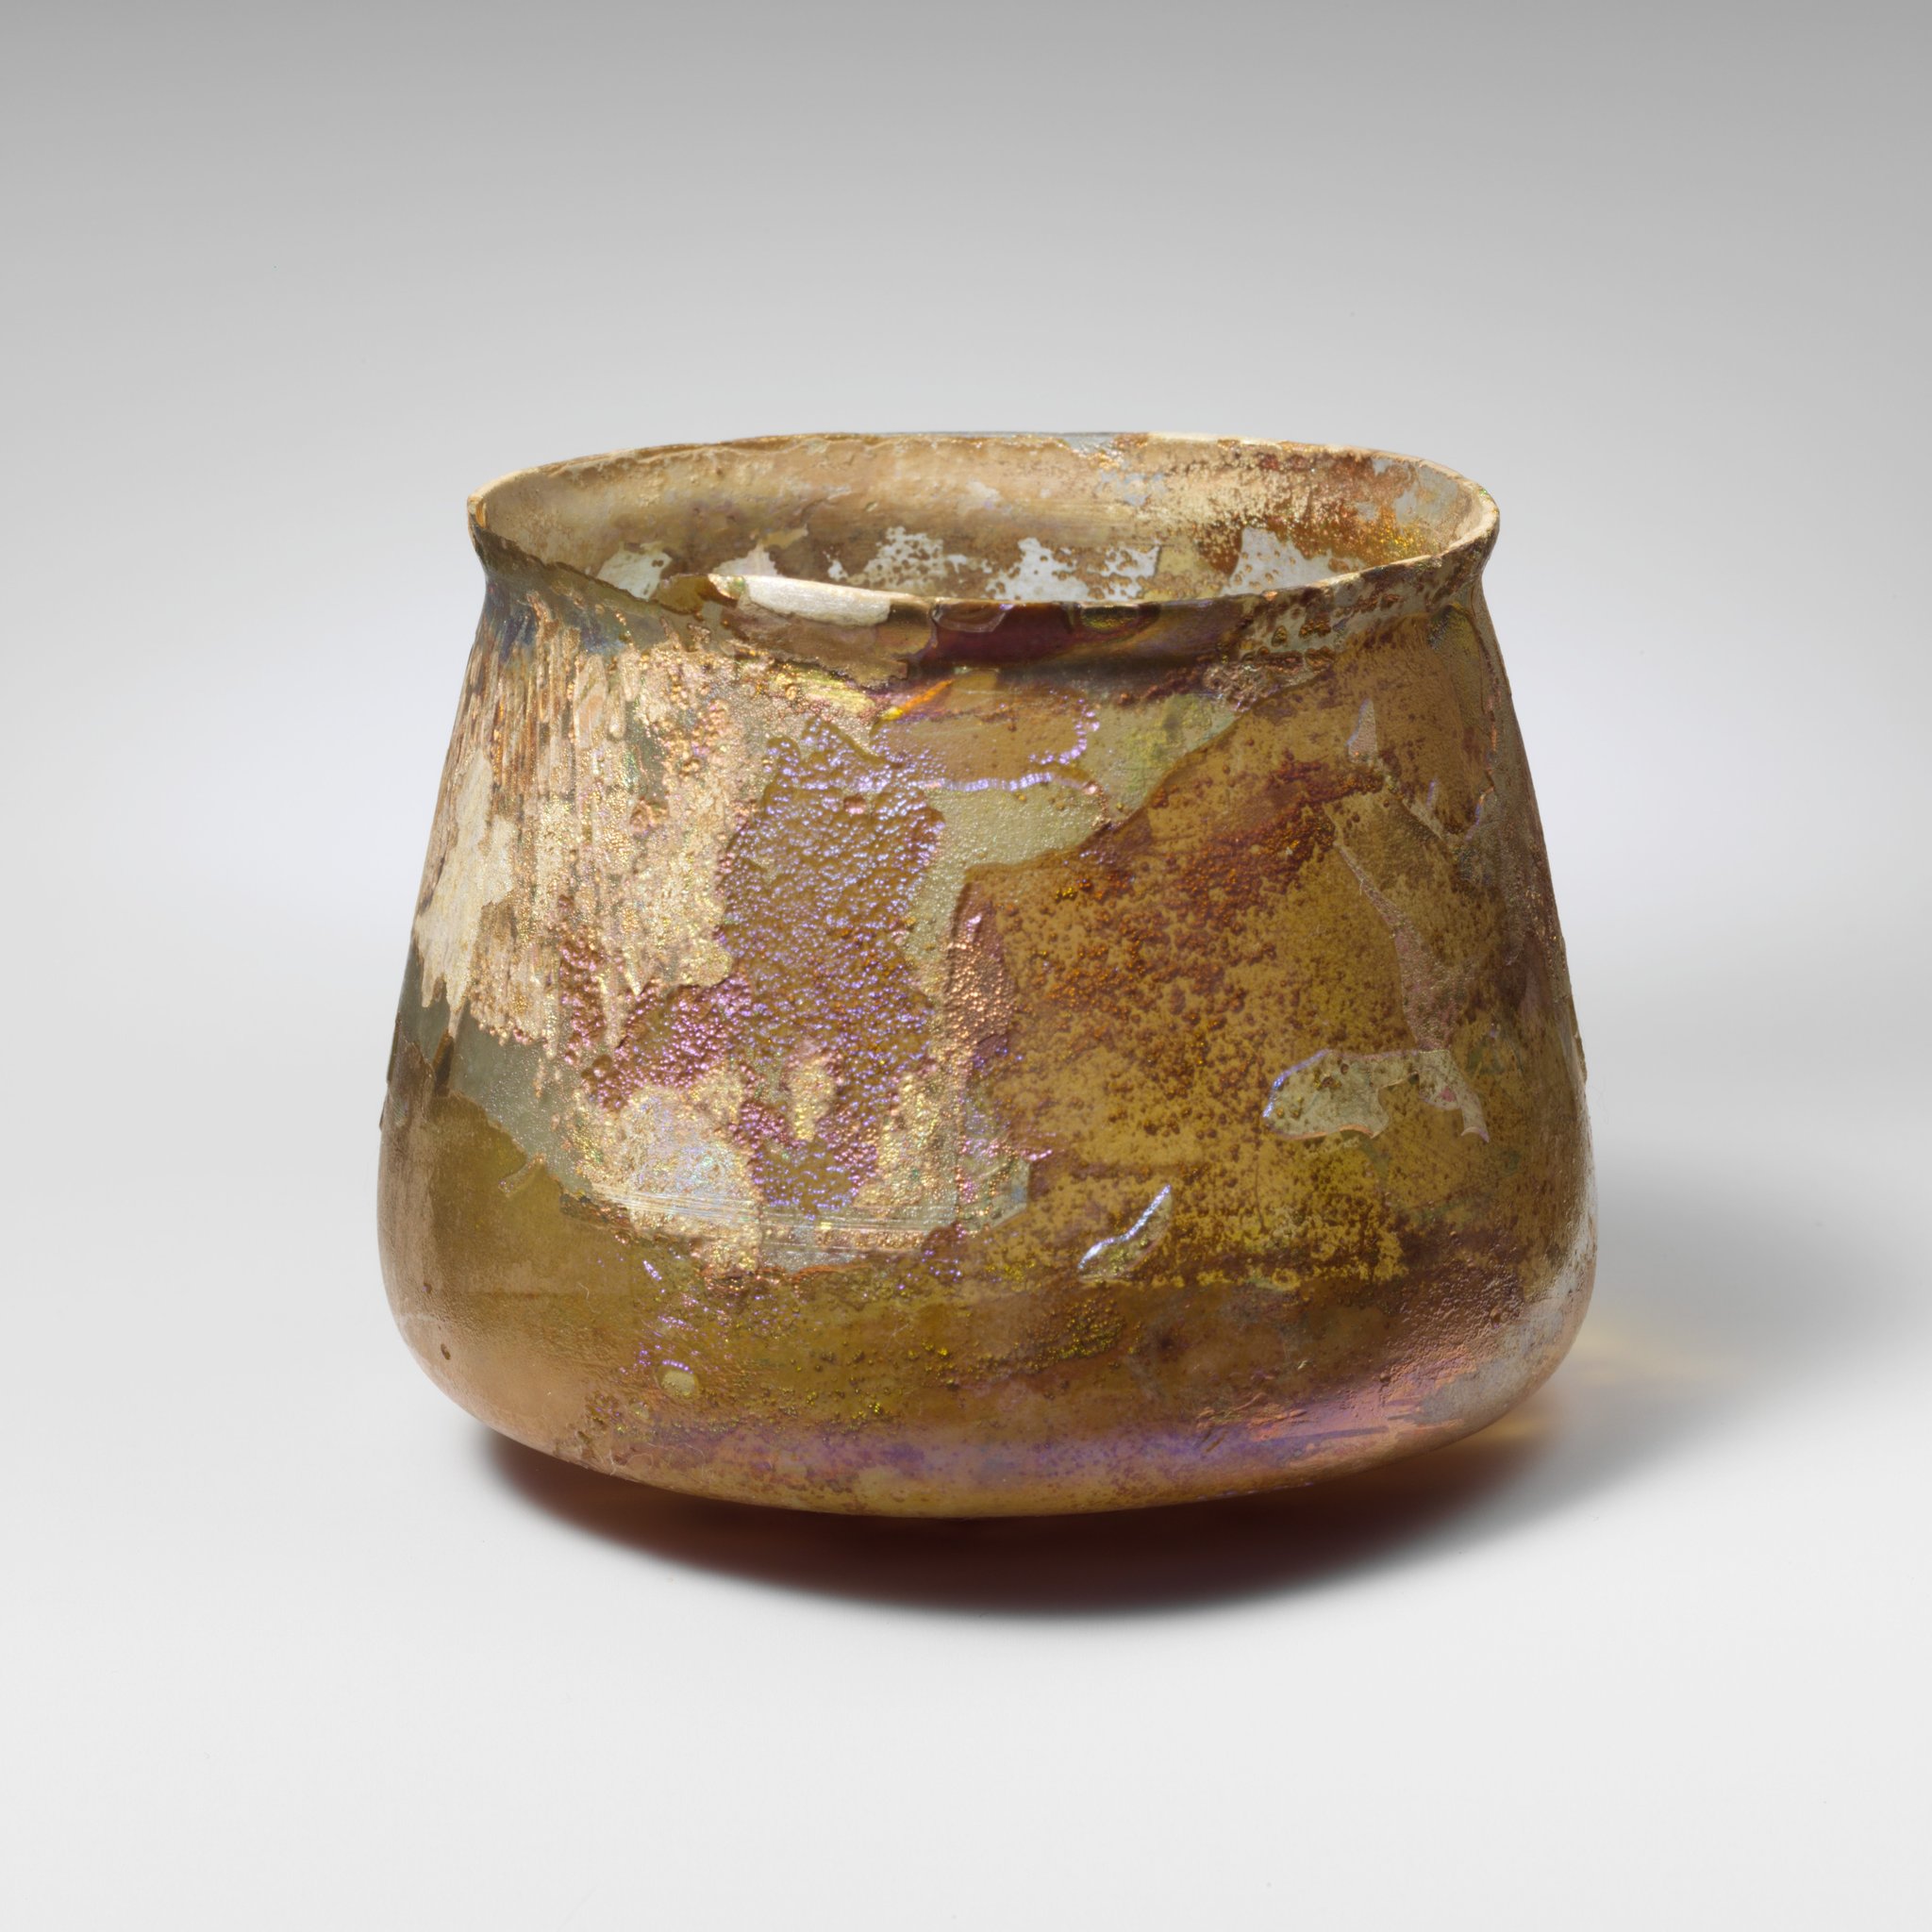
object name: cup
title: Glass cup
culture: roman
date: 101-300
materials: glass